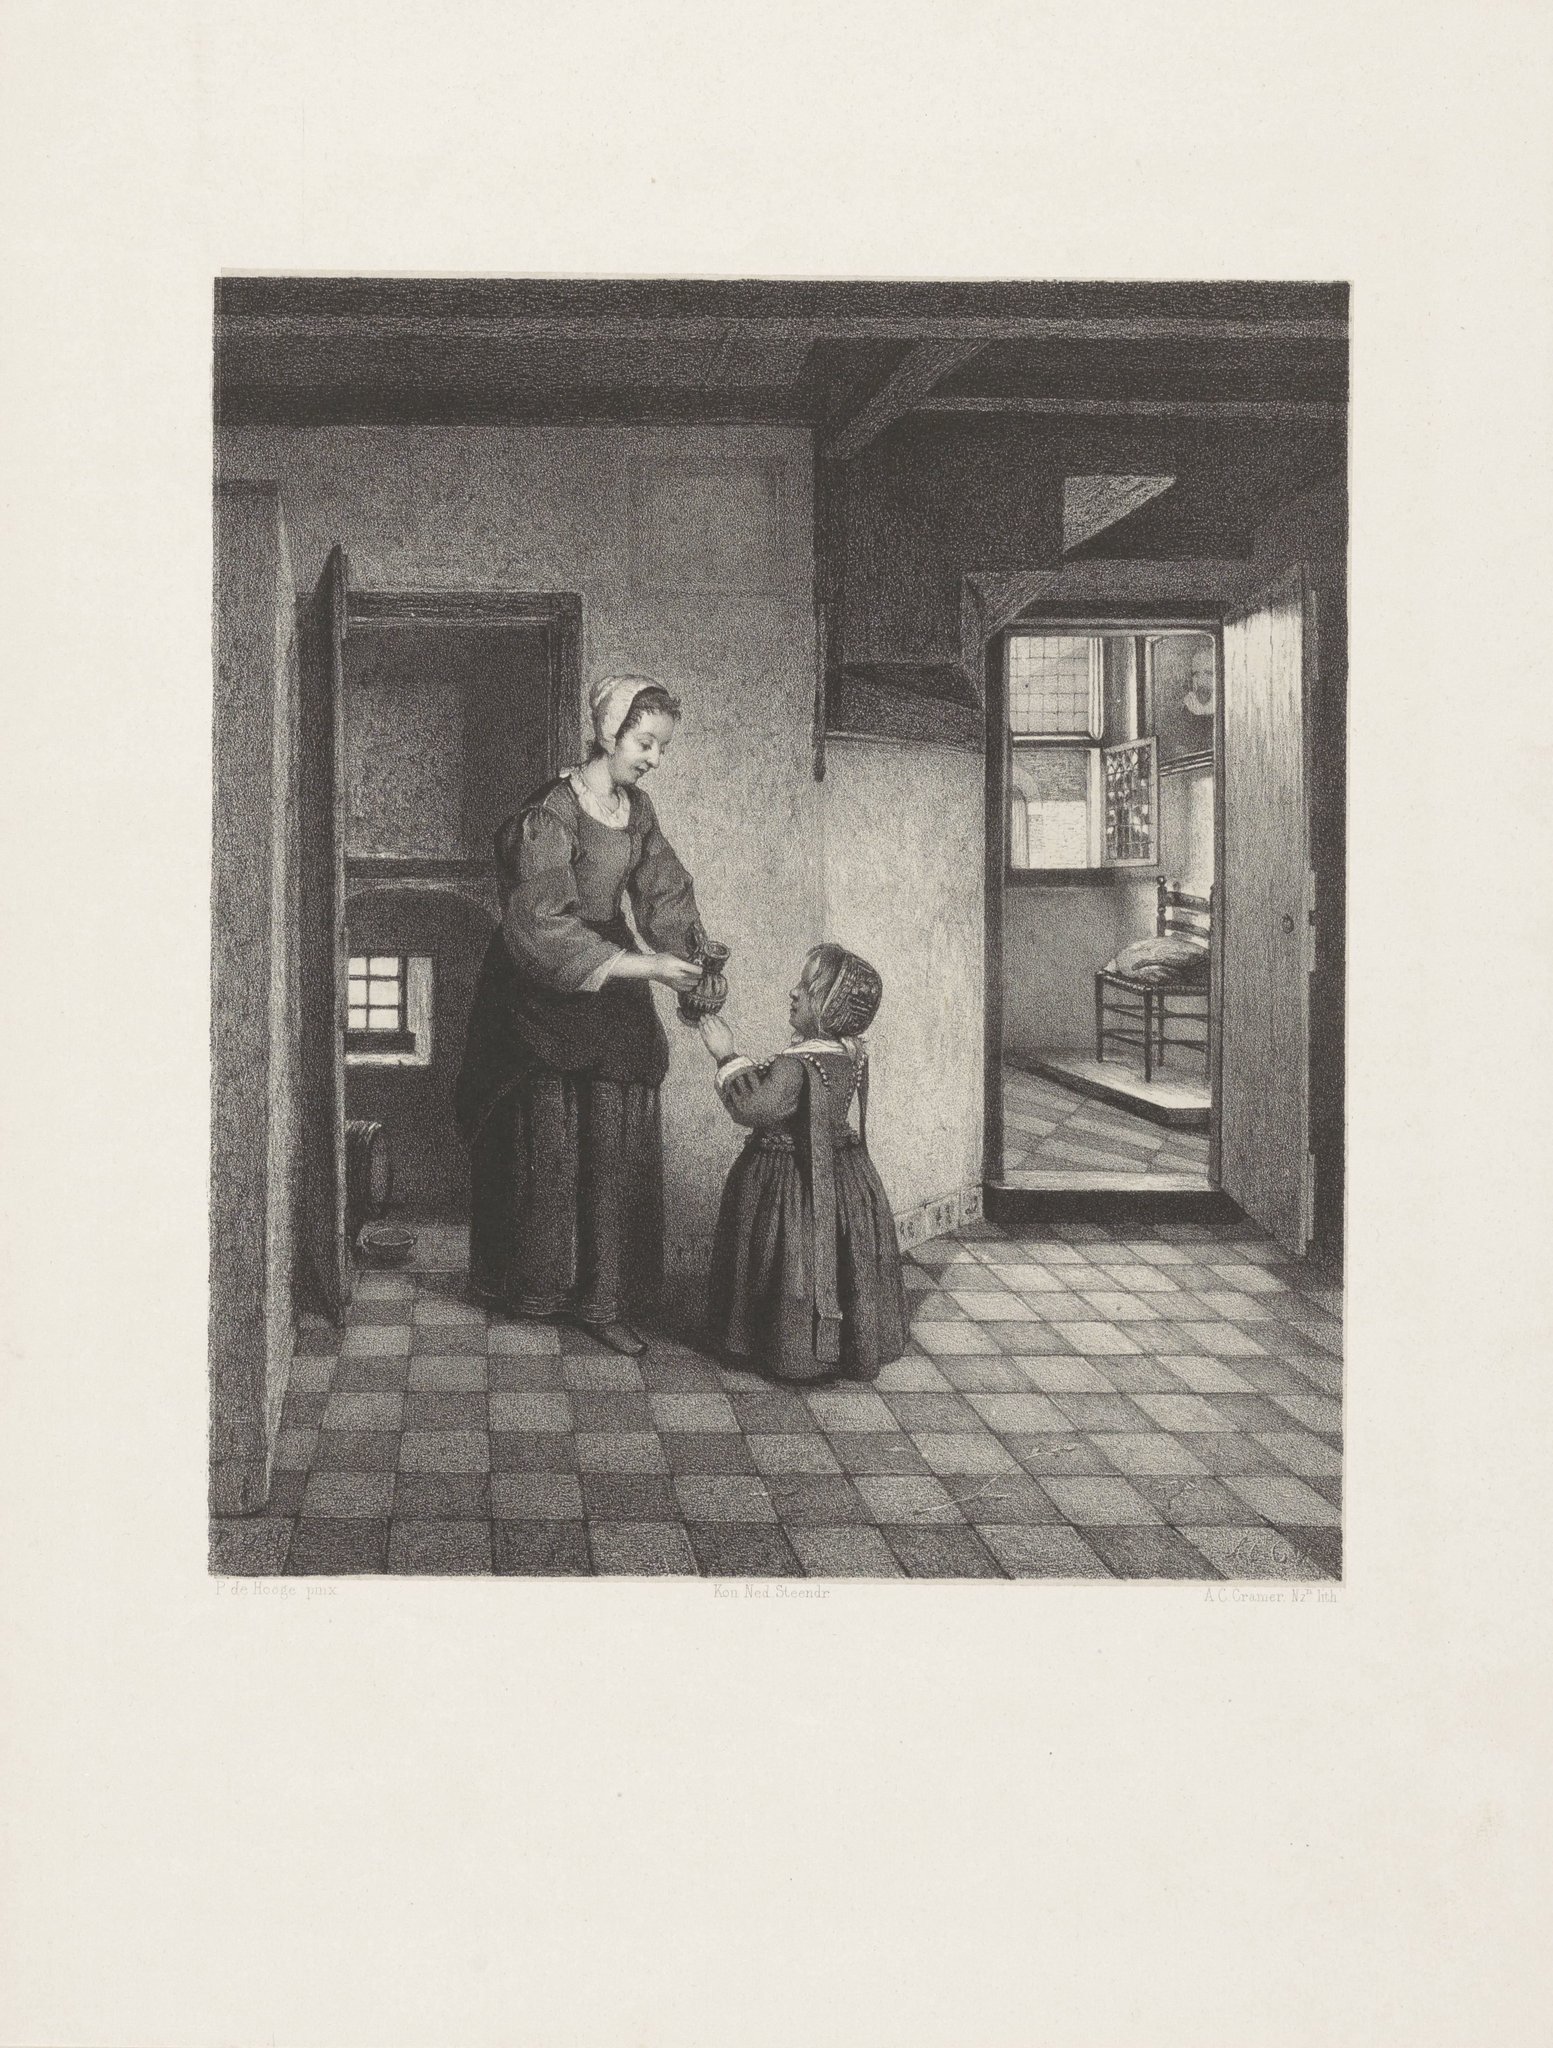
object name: print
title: Vrouw met een kind in een kelderkamer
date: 1867-1874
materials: paper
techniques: lithograph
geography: amsterdam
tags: girl (child between toddler and youth), interior of the house, container of metal: bucket, can, canister, drum, tin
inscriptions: collector's mark: Lugt 2228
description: Een vrouw met een kind in een kelderkamer met tegelvloer. Een jonge vrouw reikt een klein meisje een kan met deksel. Links en rechts doorkijkjes naar andere kamers. In de kamer rechts staat het venster open, bij het raam een stoel met kussen, aan de muur een schilderij met een mansportret.